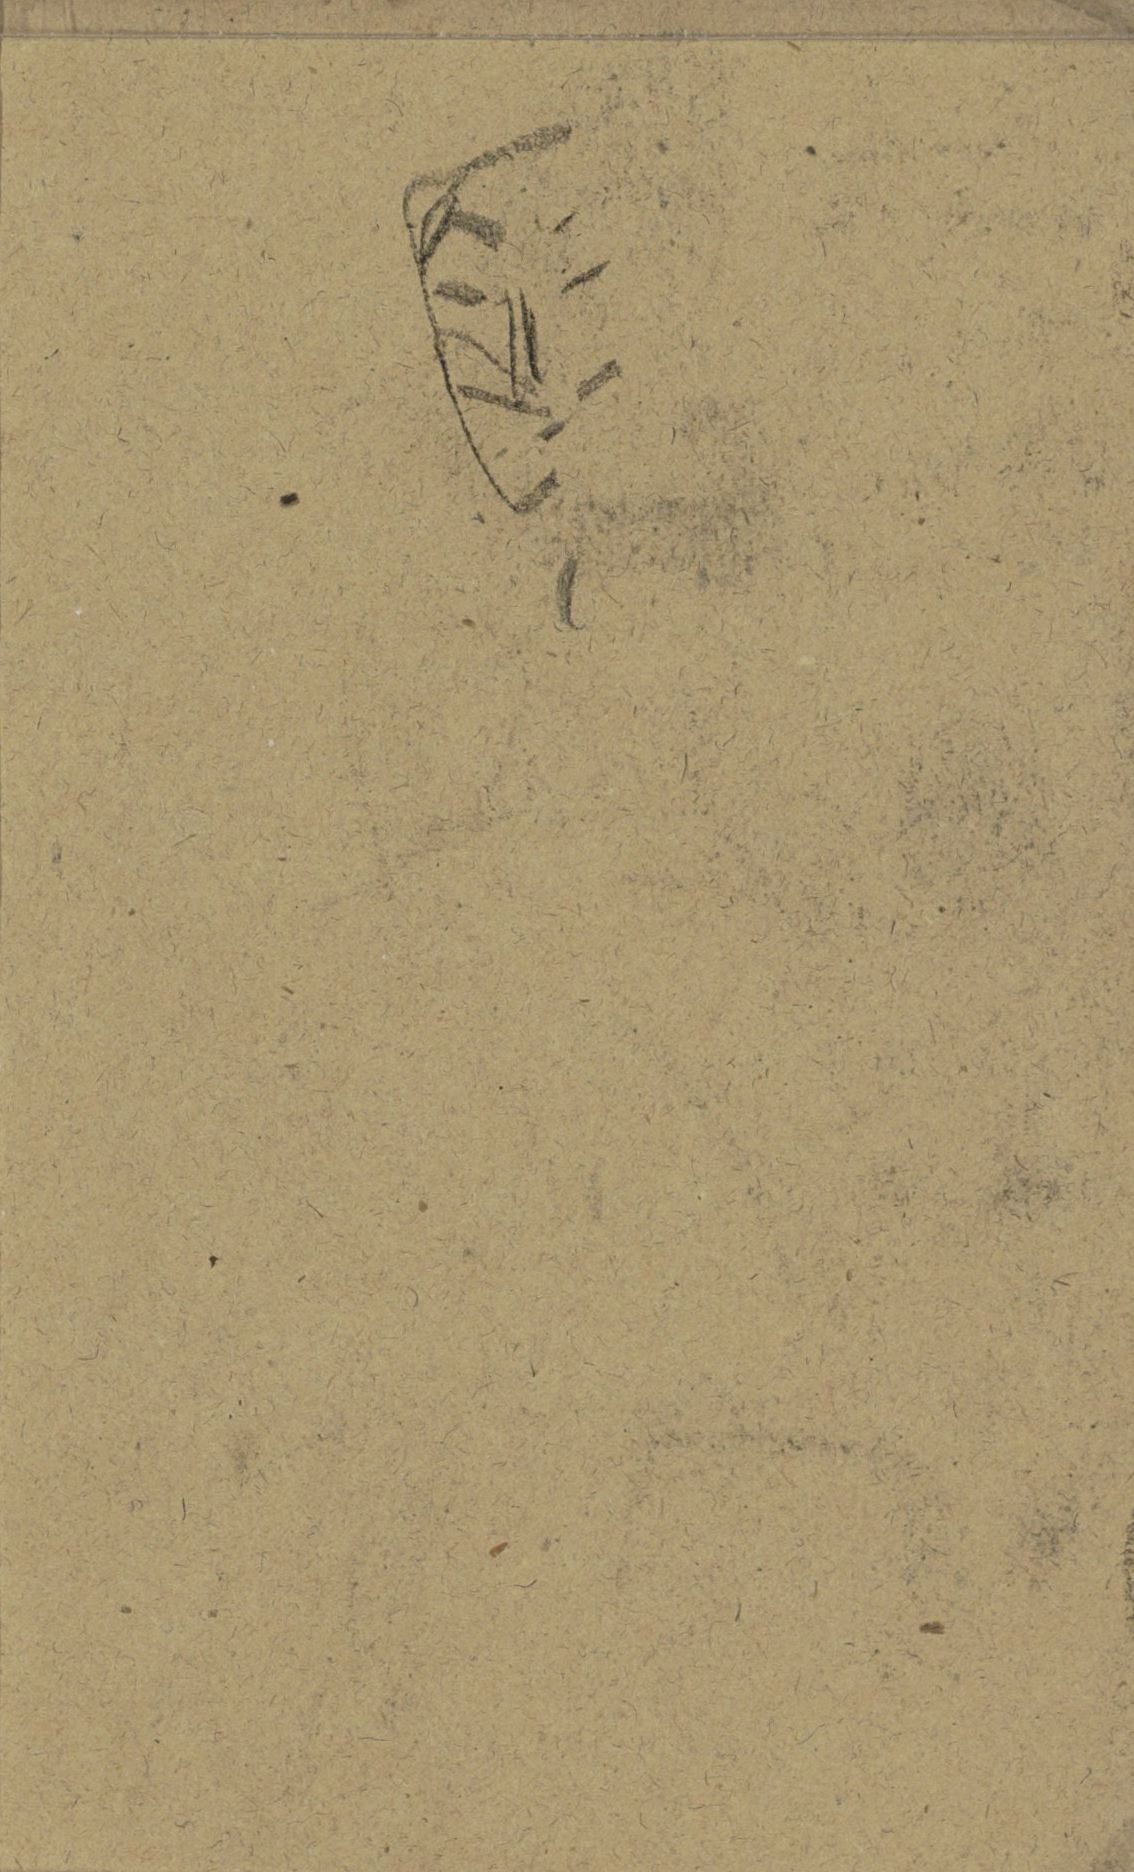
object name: endleaf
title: Studie, mogelijk van een gezicht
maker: isaac israels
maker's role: draughtsman, painter, print maker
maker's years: 1865-1934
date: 1875-1934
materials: chalk, paper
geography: amsterdam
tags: face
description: Schutblad B, achterste schutblad, uit schetsboek XXIX met 44 pagina's.